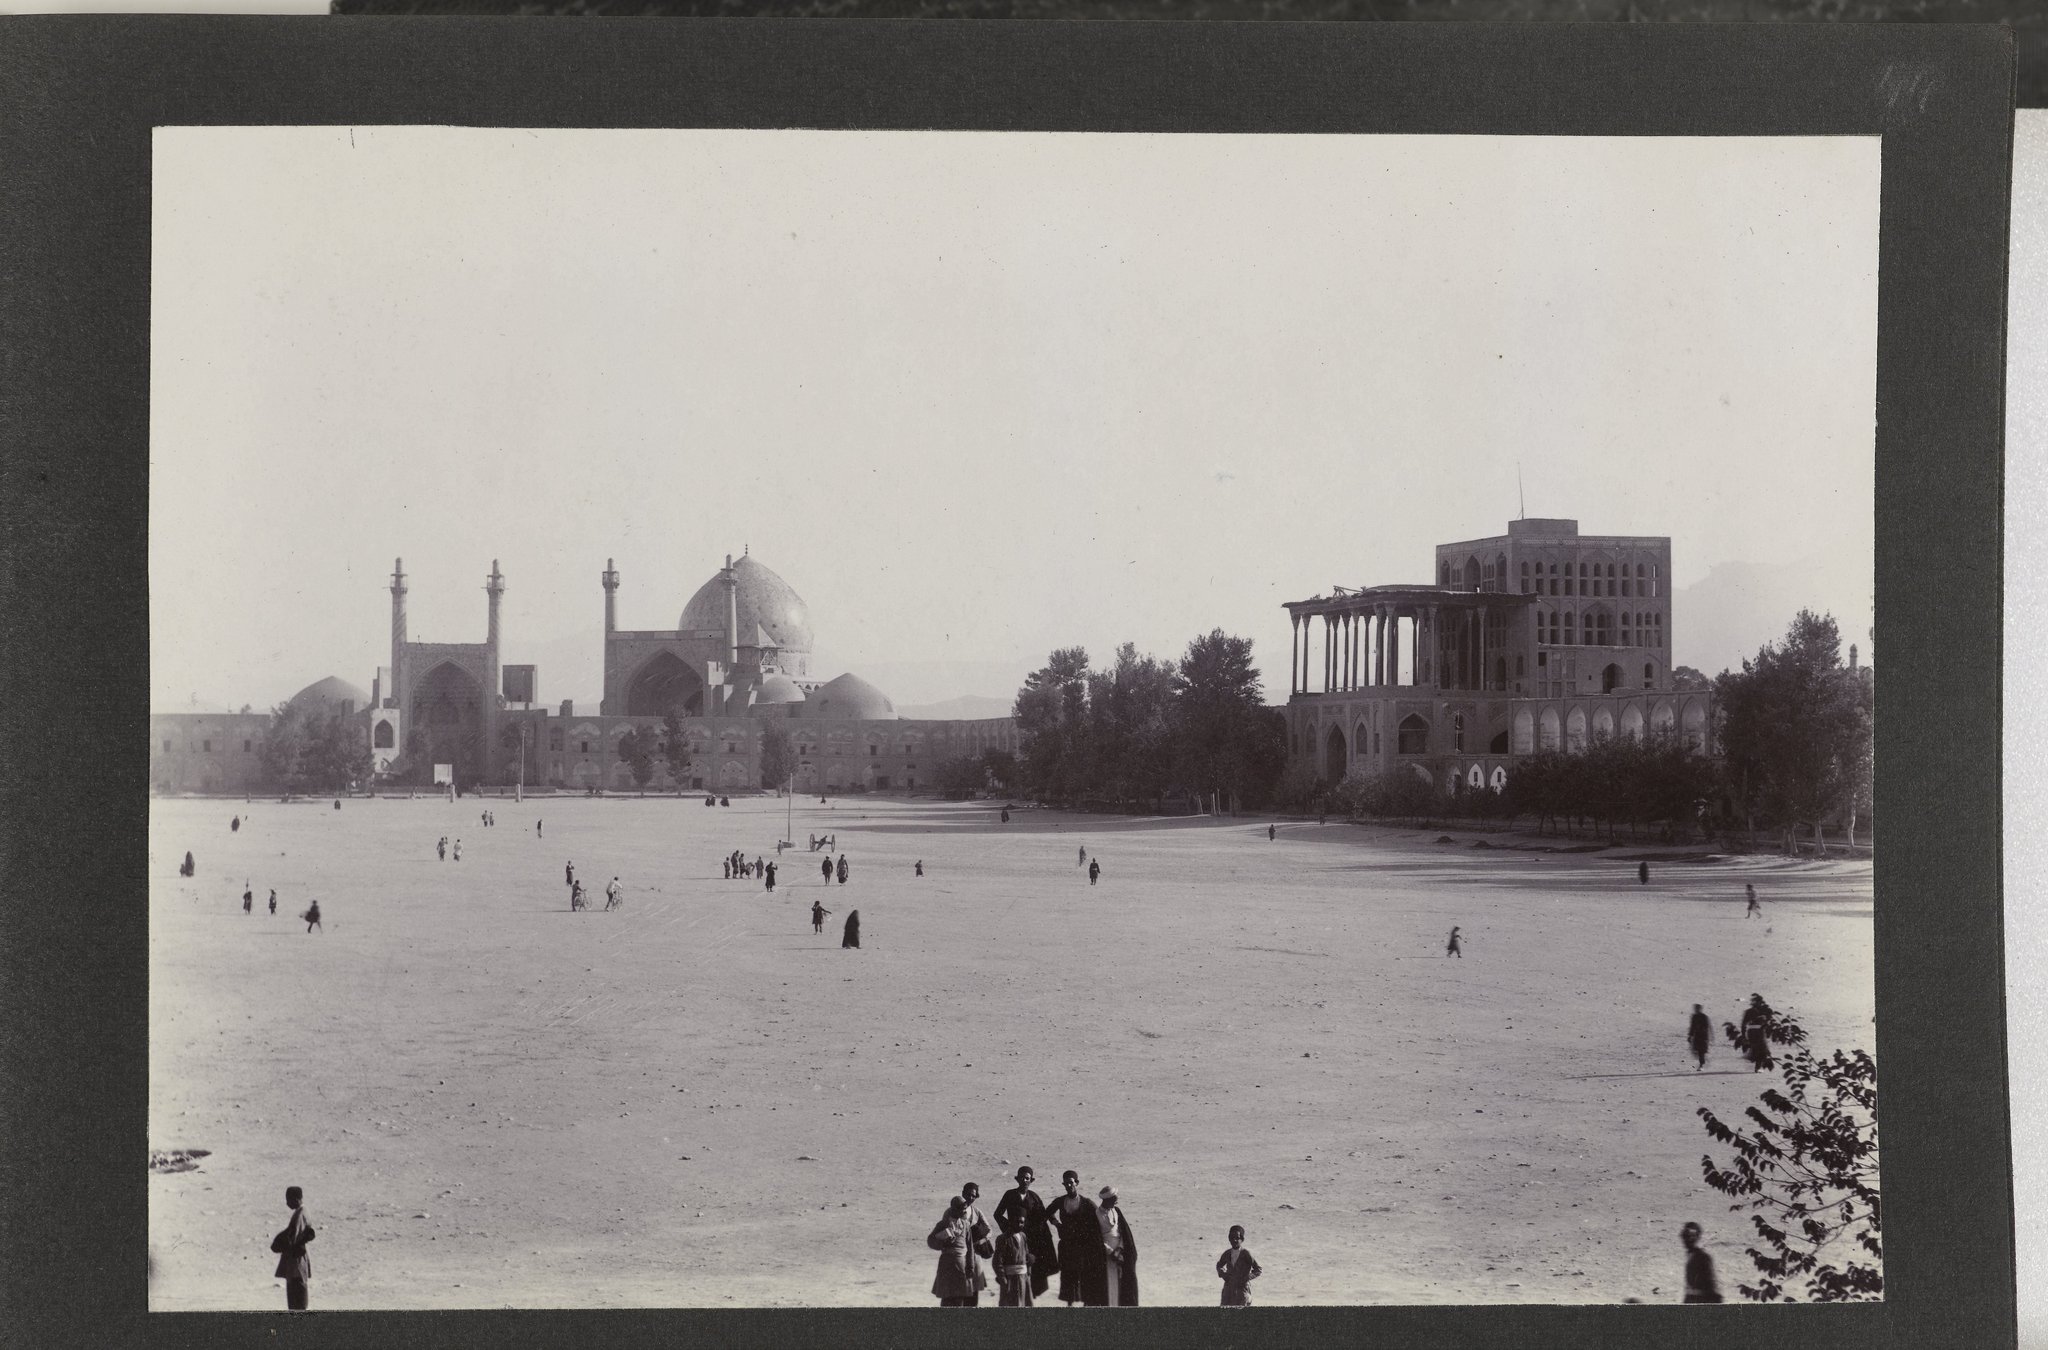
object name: photograph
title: Het Maidan Shah (Koningsplein), met links de Moskee en rechts het paleis, van waar de Shah Abas de Groote (1585-1628) de feestelykheden op het plein aanschouwde.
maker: a.g.a. van eelde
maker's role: engineer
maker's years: 1862-1950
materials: cardboard, paper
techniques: gelatin silver print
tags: isfahan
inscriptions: number: ‘44.’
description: Titel op object afkomstig uit inventaris (Verklaring der Photo's) behorend bij het album.